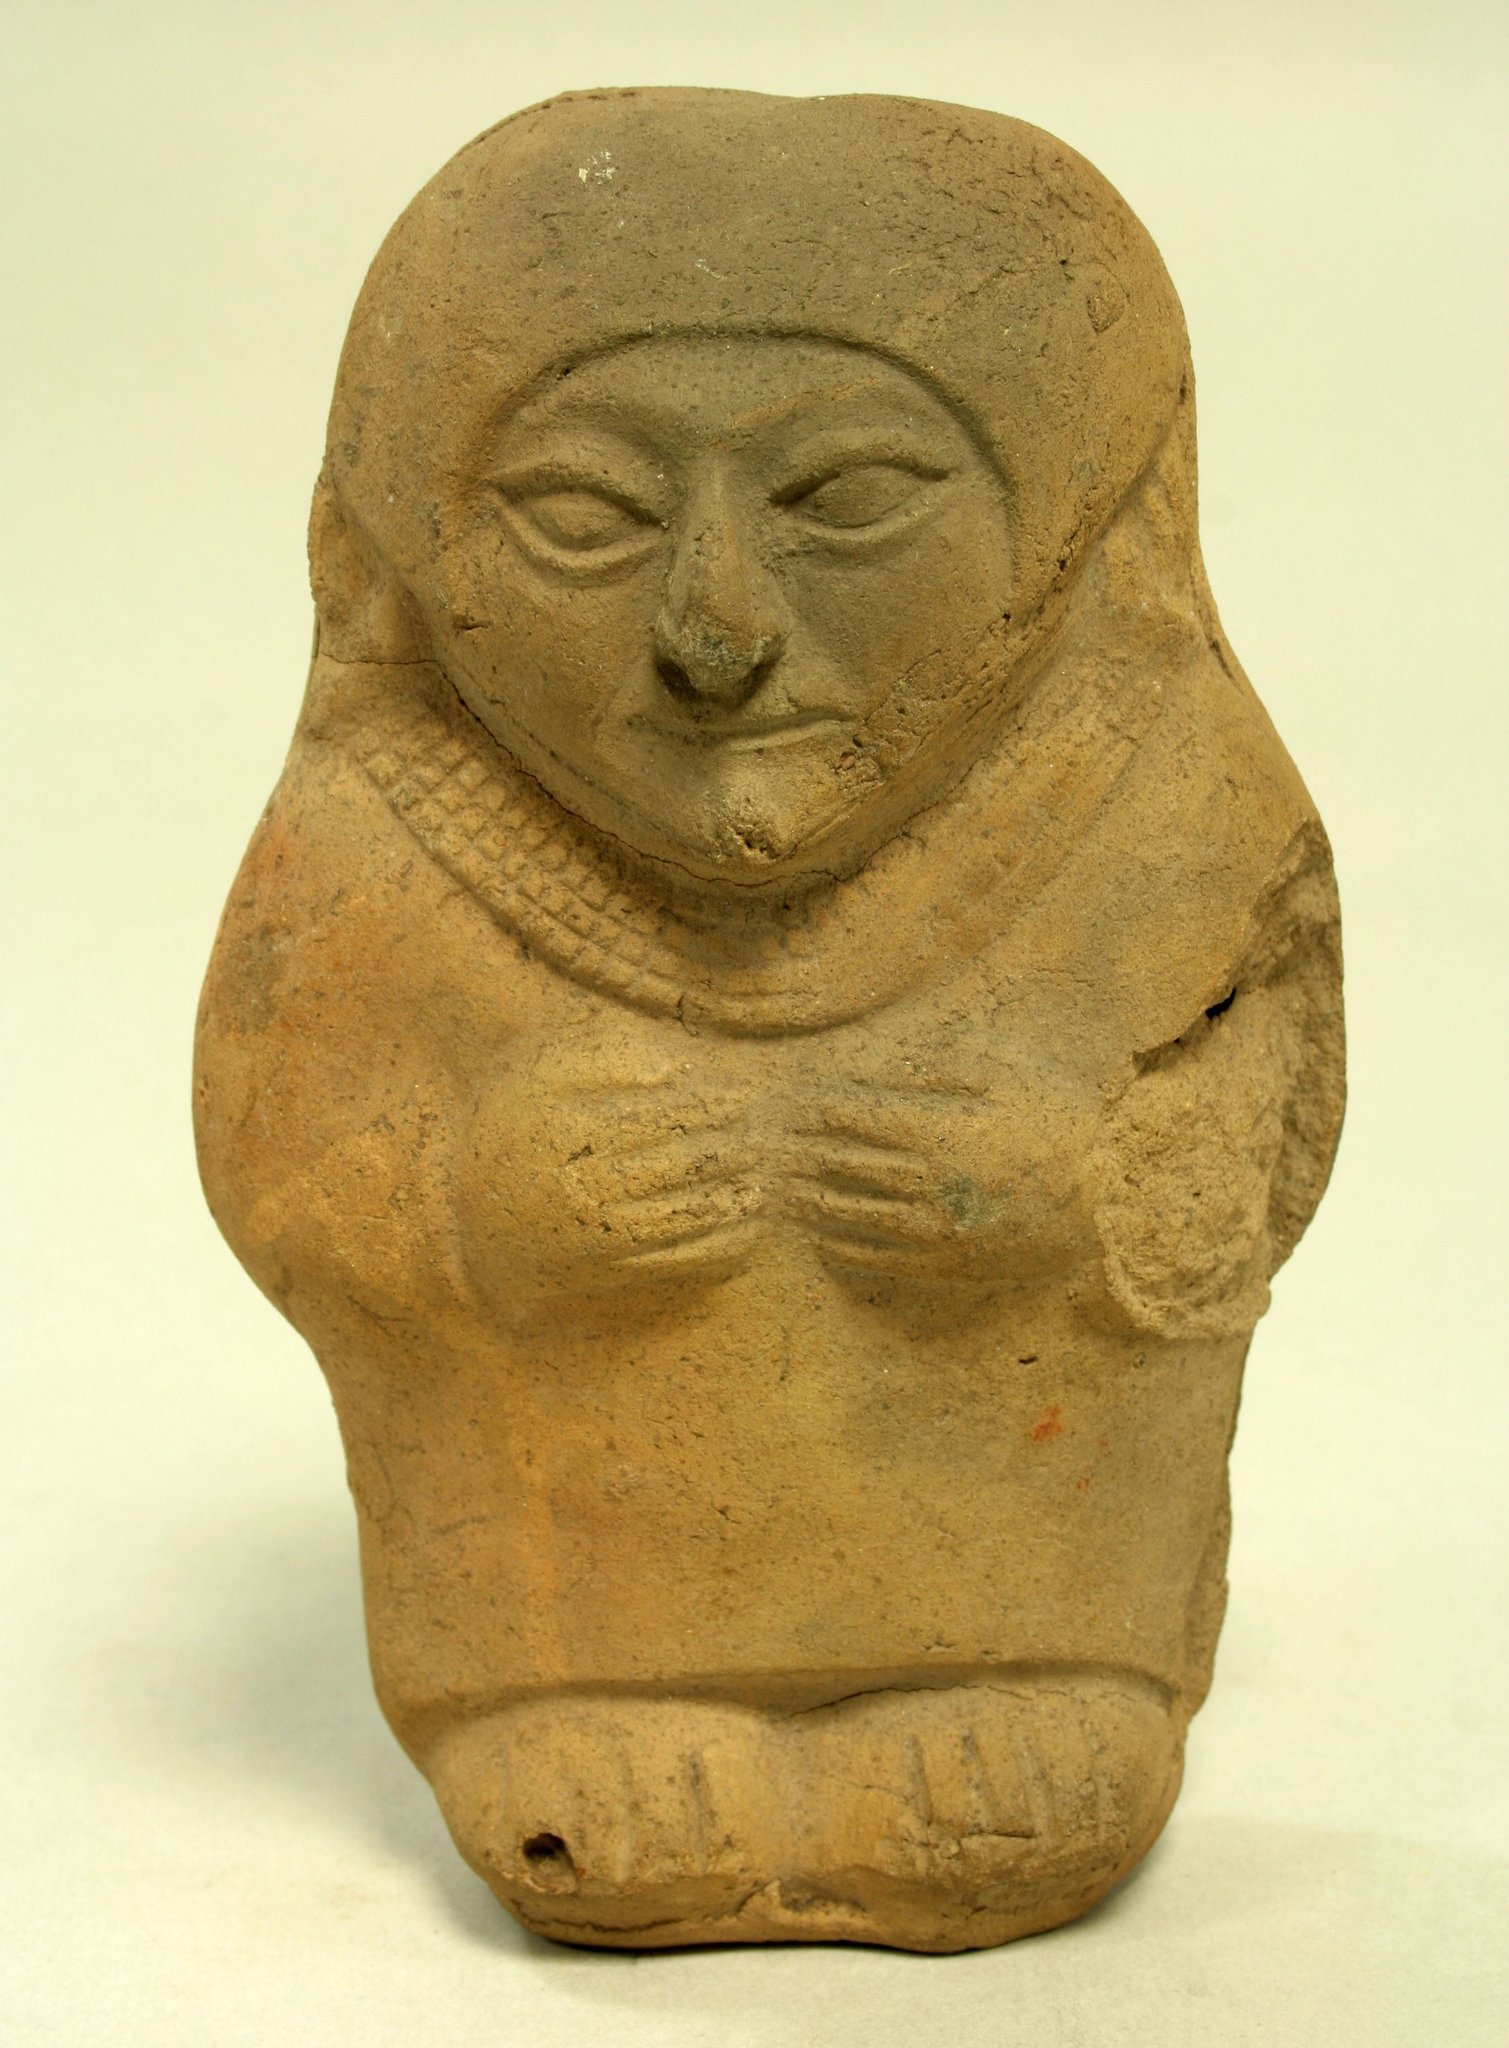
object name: figure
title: Standing Ceramic Figure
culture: moche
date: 201-500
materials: ceramic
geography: peru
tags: human figures